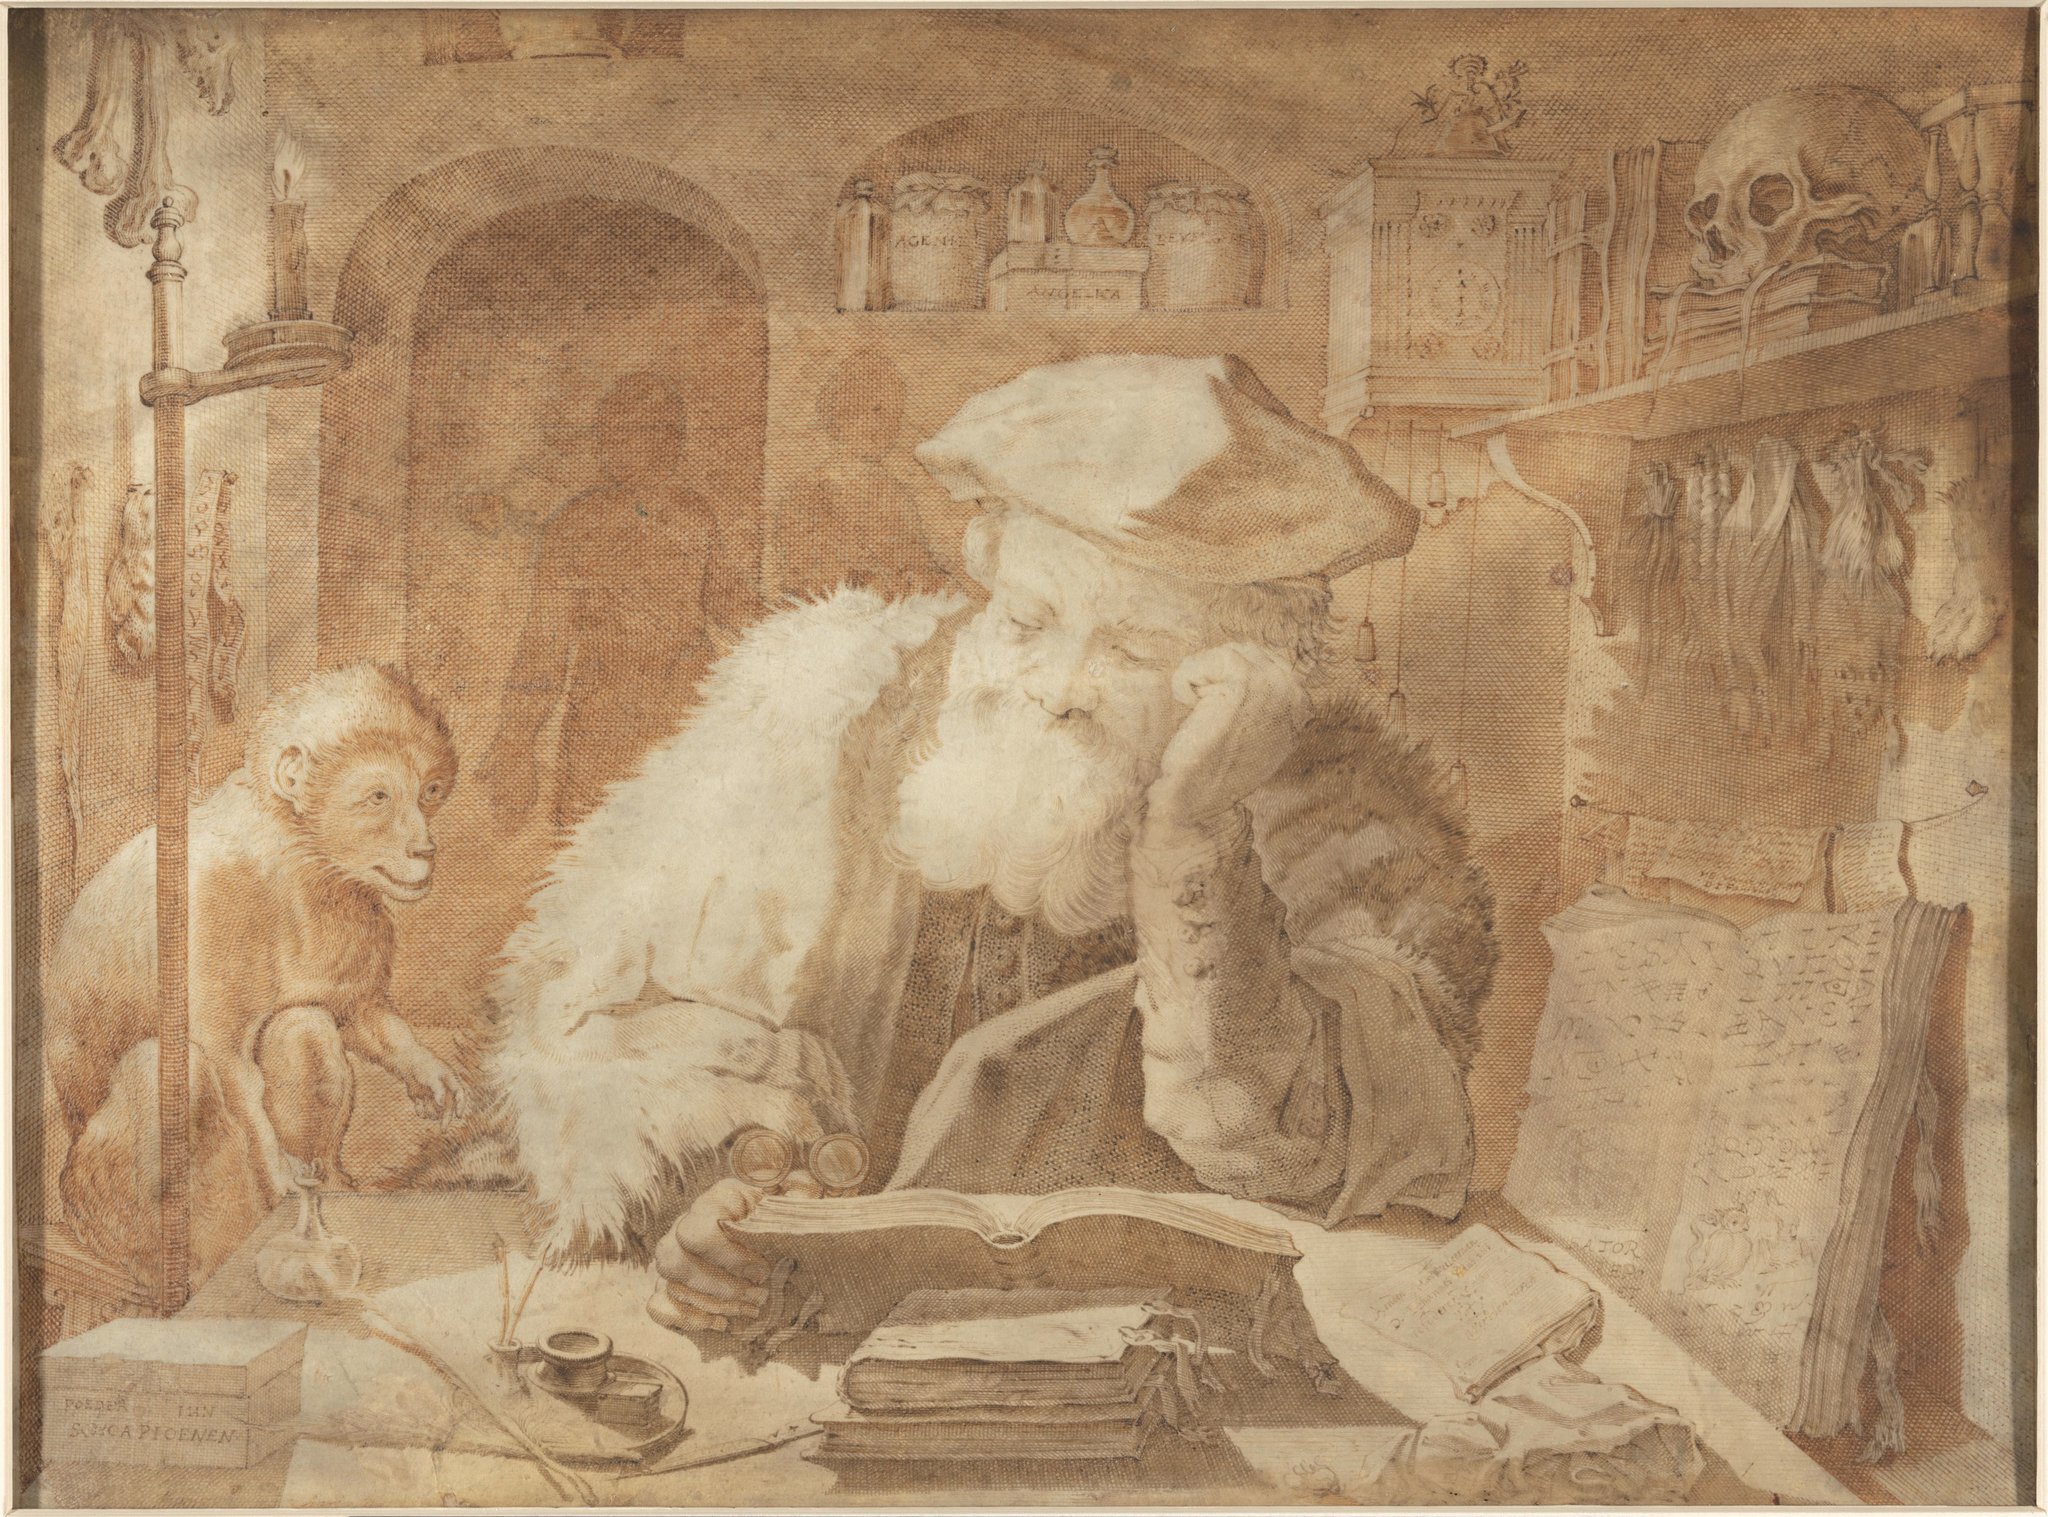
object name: drawing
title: Dr. Faust in zijn studeervertrek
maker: adriaen matham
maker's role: draughtsman, print maker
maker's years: 1599-1660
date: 1610-1660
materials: ink, parchment, wood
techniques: pen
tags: monkeys, apes, faust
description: Dr. Faust in zijn studeervertrek; links een aapje, op de achtergrond twee schimmen.